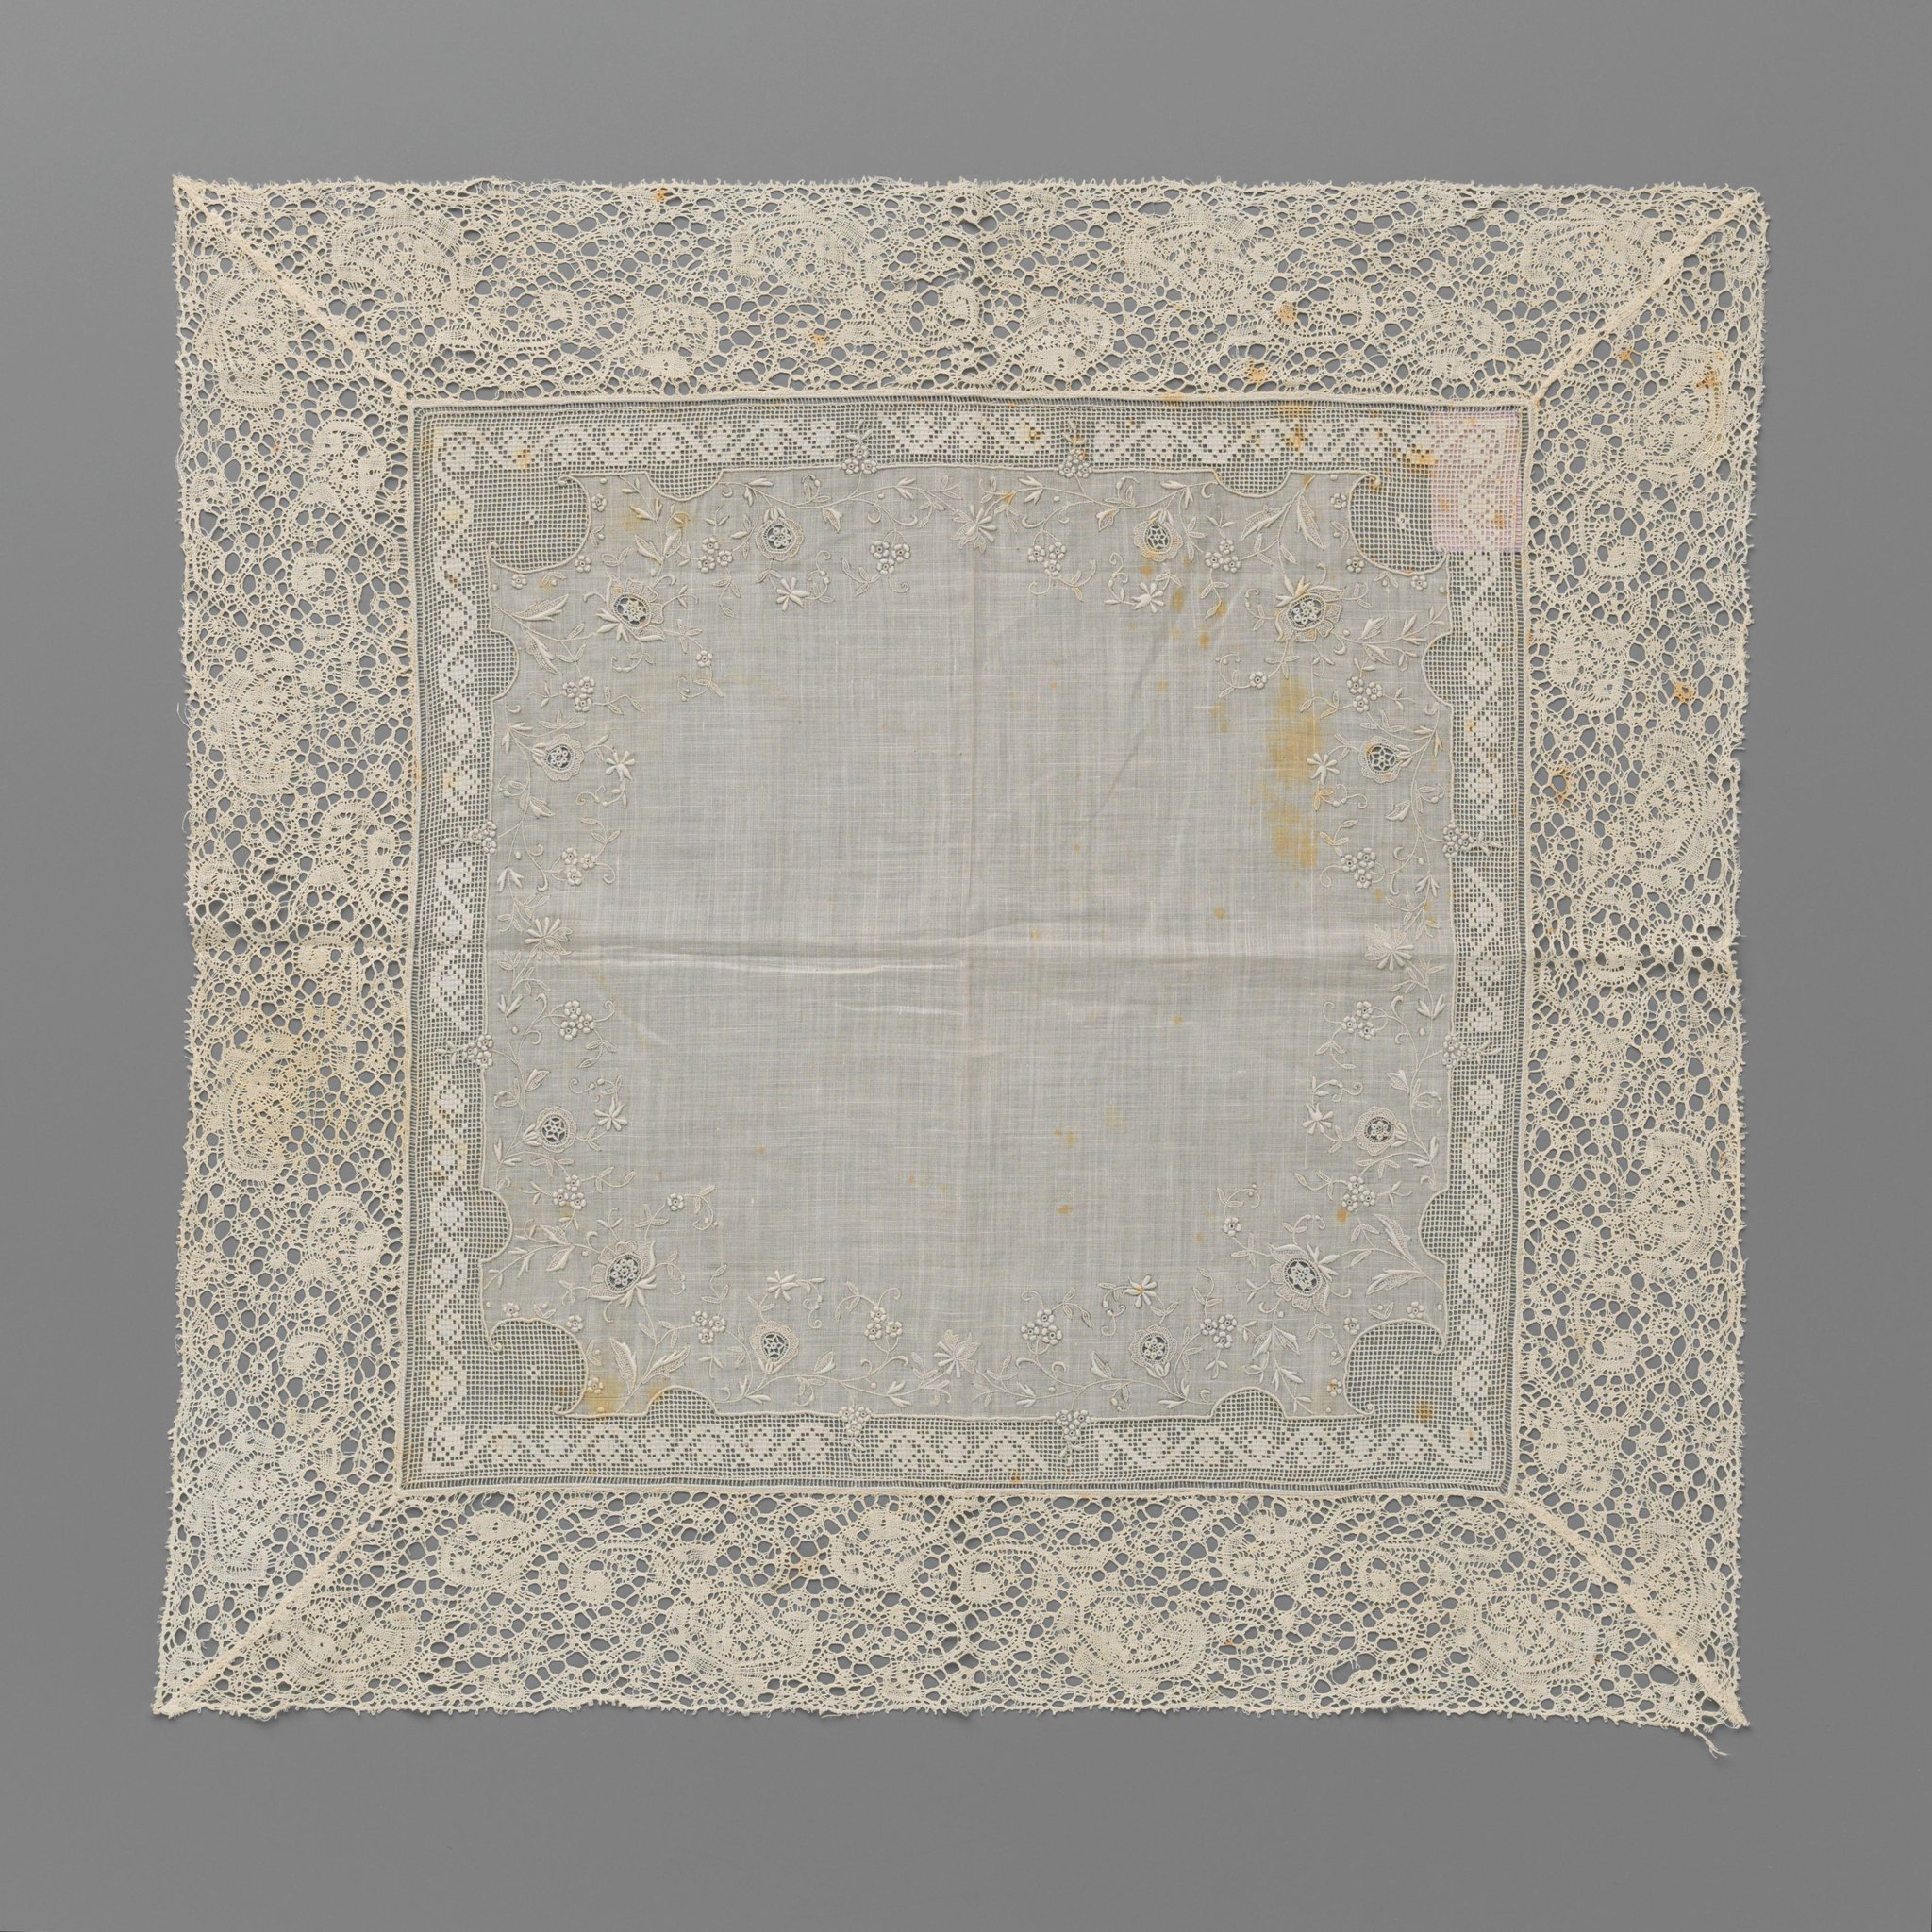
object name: handkerchief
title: Zakdoek van batist met witwerk dat doorloopt in een rand kantborduurwerk met zigzag-patroon en rondom een rand kloskant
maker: Anonymous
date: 1700-1799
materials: cotton, linen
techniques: lace, embroidered, weave, embroidery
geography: europe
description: Zakdoek van naturelkleurig batist met borduurwerk - witwerk - met daaromheen een opengewerkte rand van kantborduurwerk: werk met samengetrokken draden dat vanuit het batist doorloopt en is doorgestopt. Het open naaiwerk geeft door het vierkante raster dat op een geknoopt netwerk lijkt de indruk van filetkant. Aan dit geheel is rondom een rand kloskant genaaid: Binche-kant. Vierkant model met rechte randen. Het wit op wit borduurwerk bevindt zich in een aaneengesloten patroon langs de rand van het batist en bestaat uit ijle omkrullende ranken met kleine blaadjes en clusters van drie rozetbloempjes waartussen enkele grotere bloemen staan, verschillend van vorm en met opengewerkte bloemharten. De hoeken hebben elk drie holle schulpen. Het werk met samengetrokken draden heeft een vierkant raster waarin met doorstopwerk een zigzag-patroon met roosjes is gemaakt. De zigzag wordt hier en daar onderbroken door drie geborduurde rozetbloempjes. Een brede strook achttiende eeuws kant is om het geheel genaaid, met naden bij de hoekpunten. Het kant heeft een zich herhalend patroon van een ovale bloem en een liggend pluimvormig blad. De motieven zijn gemaakt in linnenslag met opengewerkte randjes en kleine uitsparingen. Ze zijn met elkaar verbonden door een geringde sneeuwvlokkengrond. In de motieven is als siergrond een sneeuwvlokkengrond zonder ringen toegepast. De rechte randen zijn afgewerkt met picots.